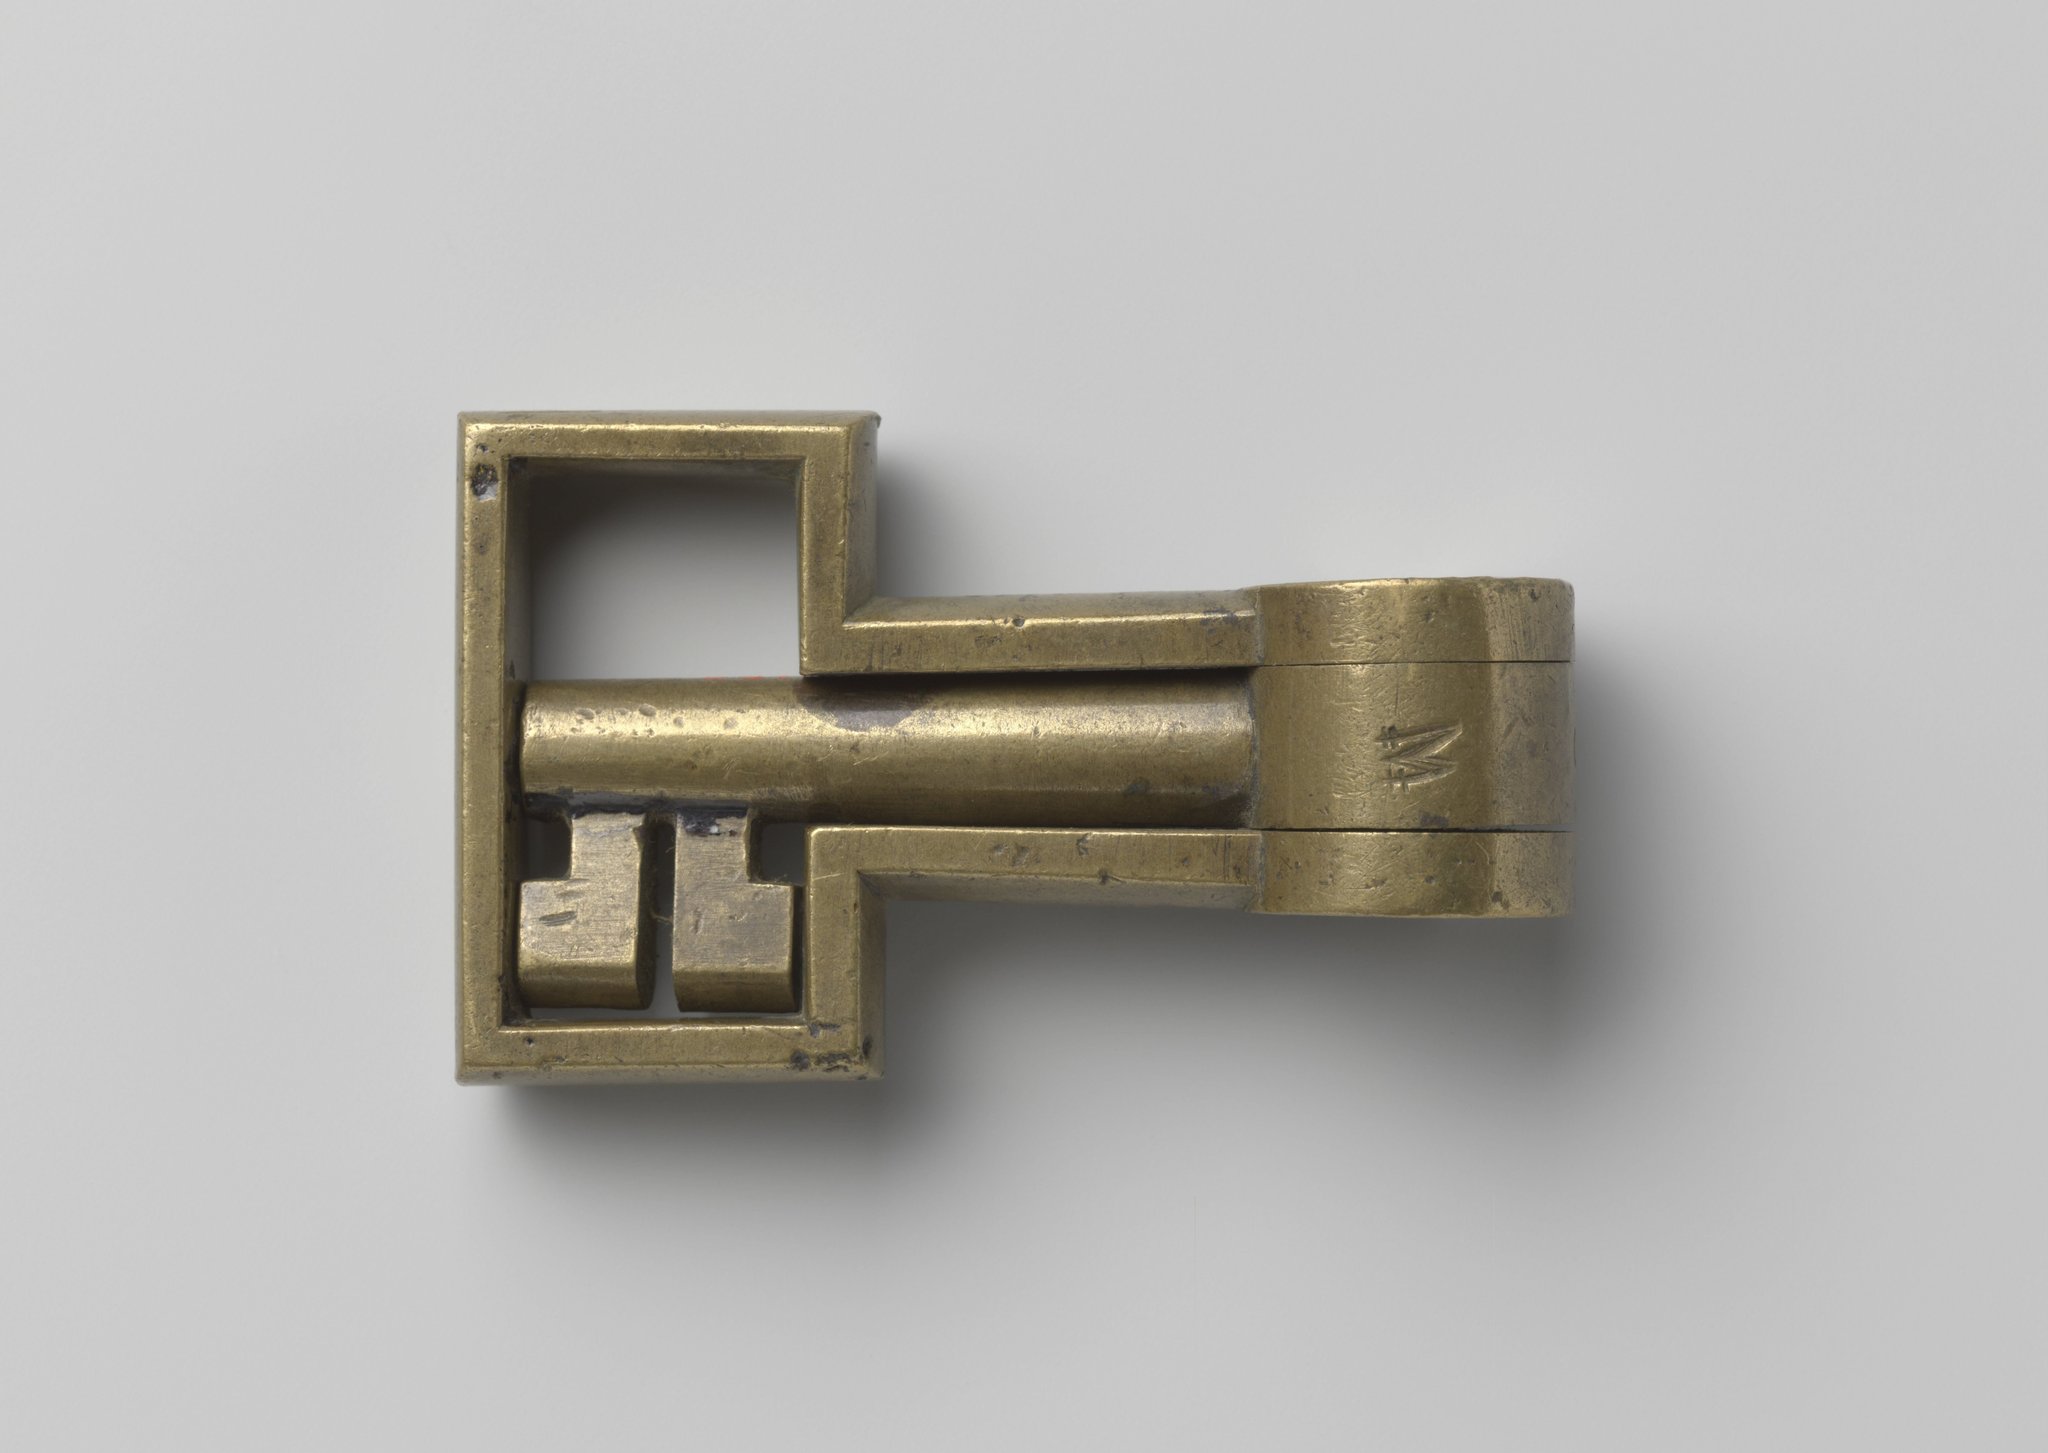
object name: key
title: Vouwsleutel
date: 1800-1900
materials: bronze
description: Vouwsleutel waarvan de greep over pijp en baard heen klapt.